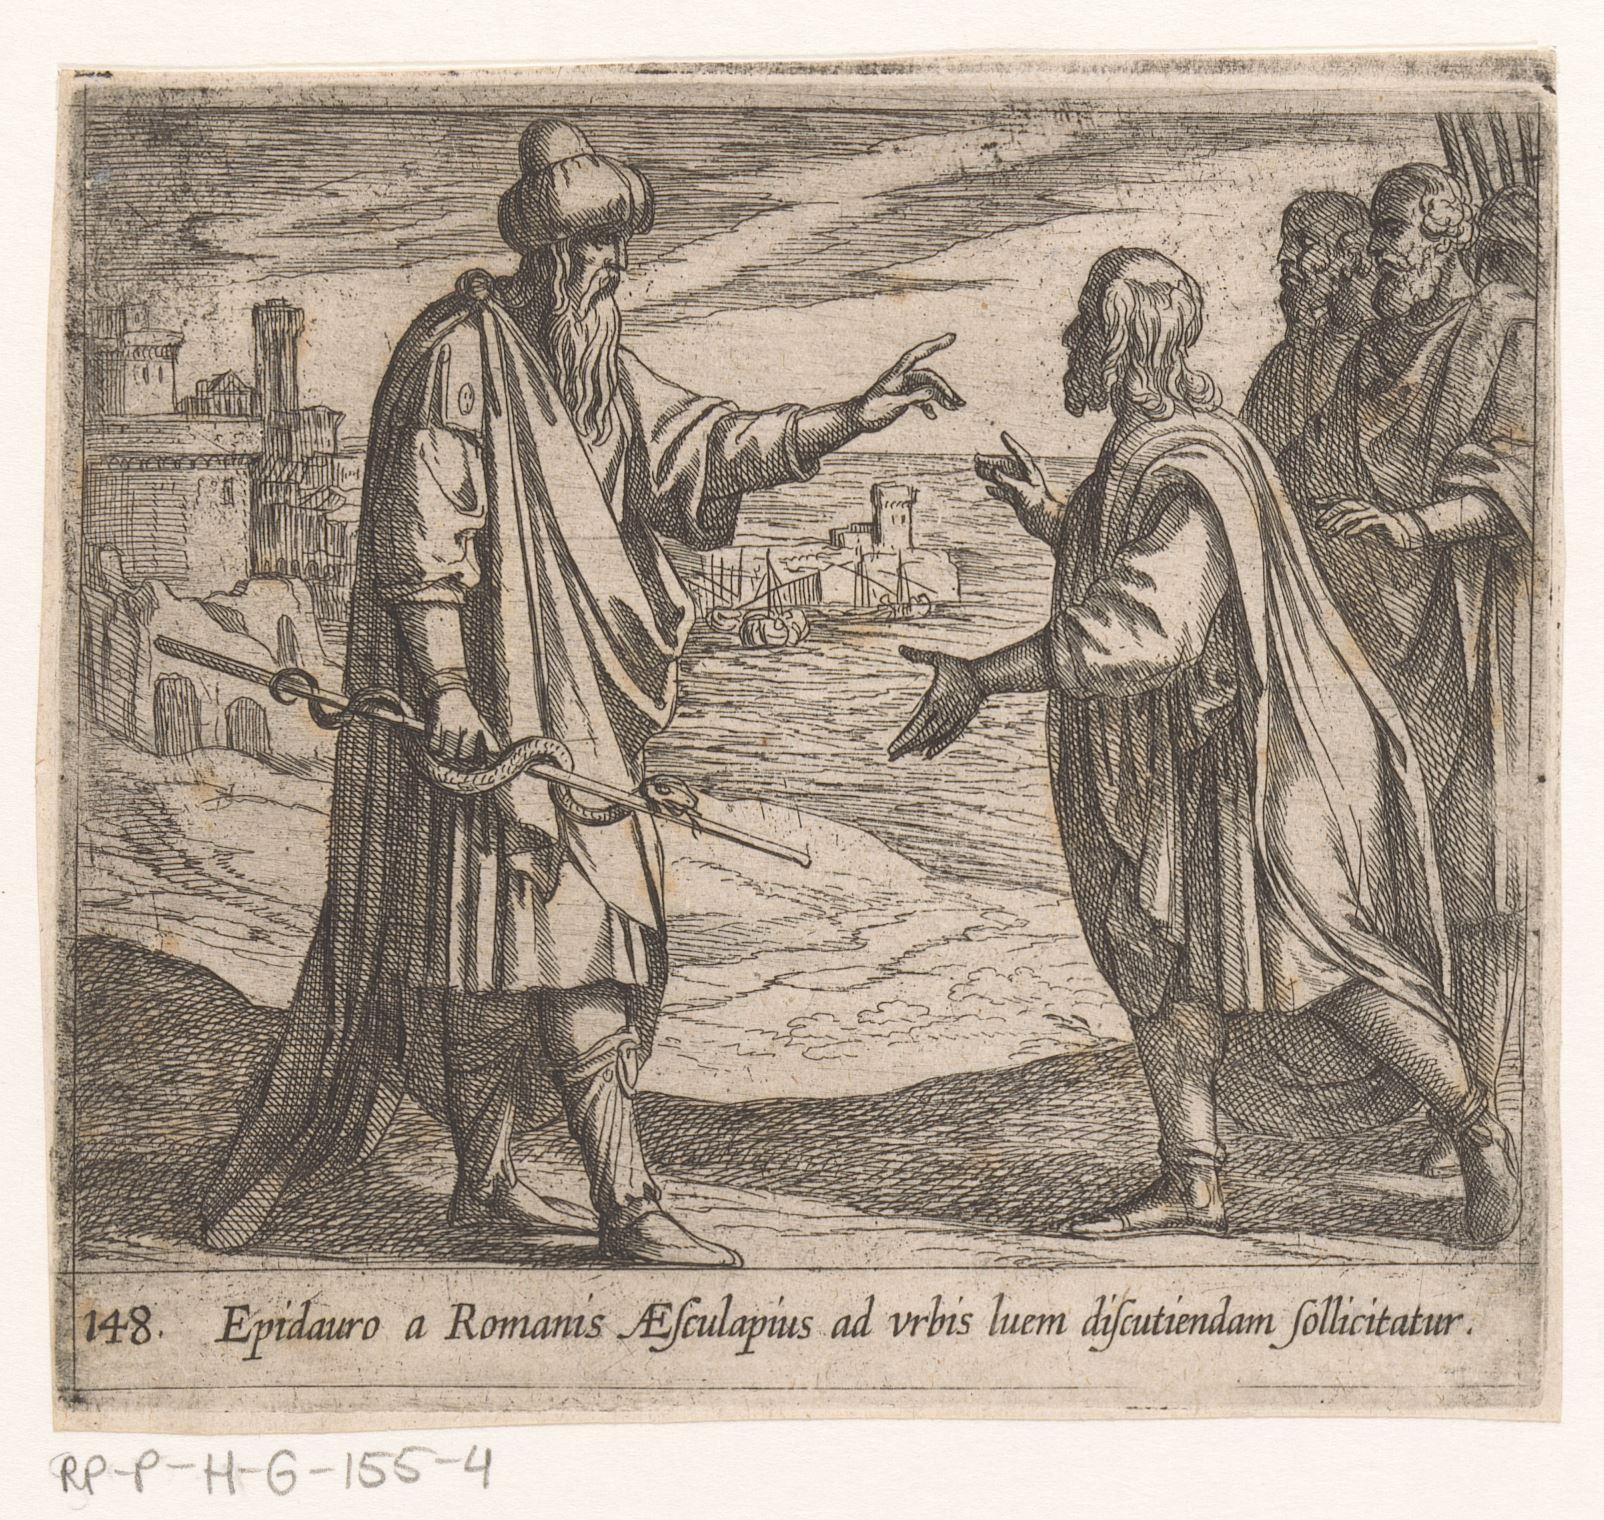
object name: print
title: Epidauro a Romanis Aesculapius ad urbis Iuem discutiendam sollicitatur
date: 1606-1638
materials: paper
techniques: etching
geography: amsterdam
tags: (story of) aesculapius (asclepius)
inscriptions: collector's mark: ‘Hinloopen’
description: Deze prent maakt deel uit van een reeks van 150 prenten (+ titelprent) met voorstellingen van de Metamorfosen van Ovidius.